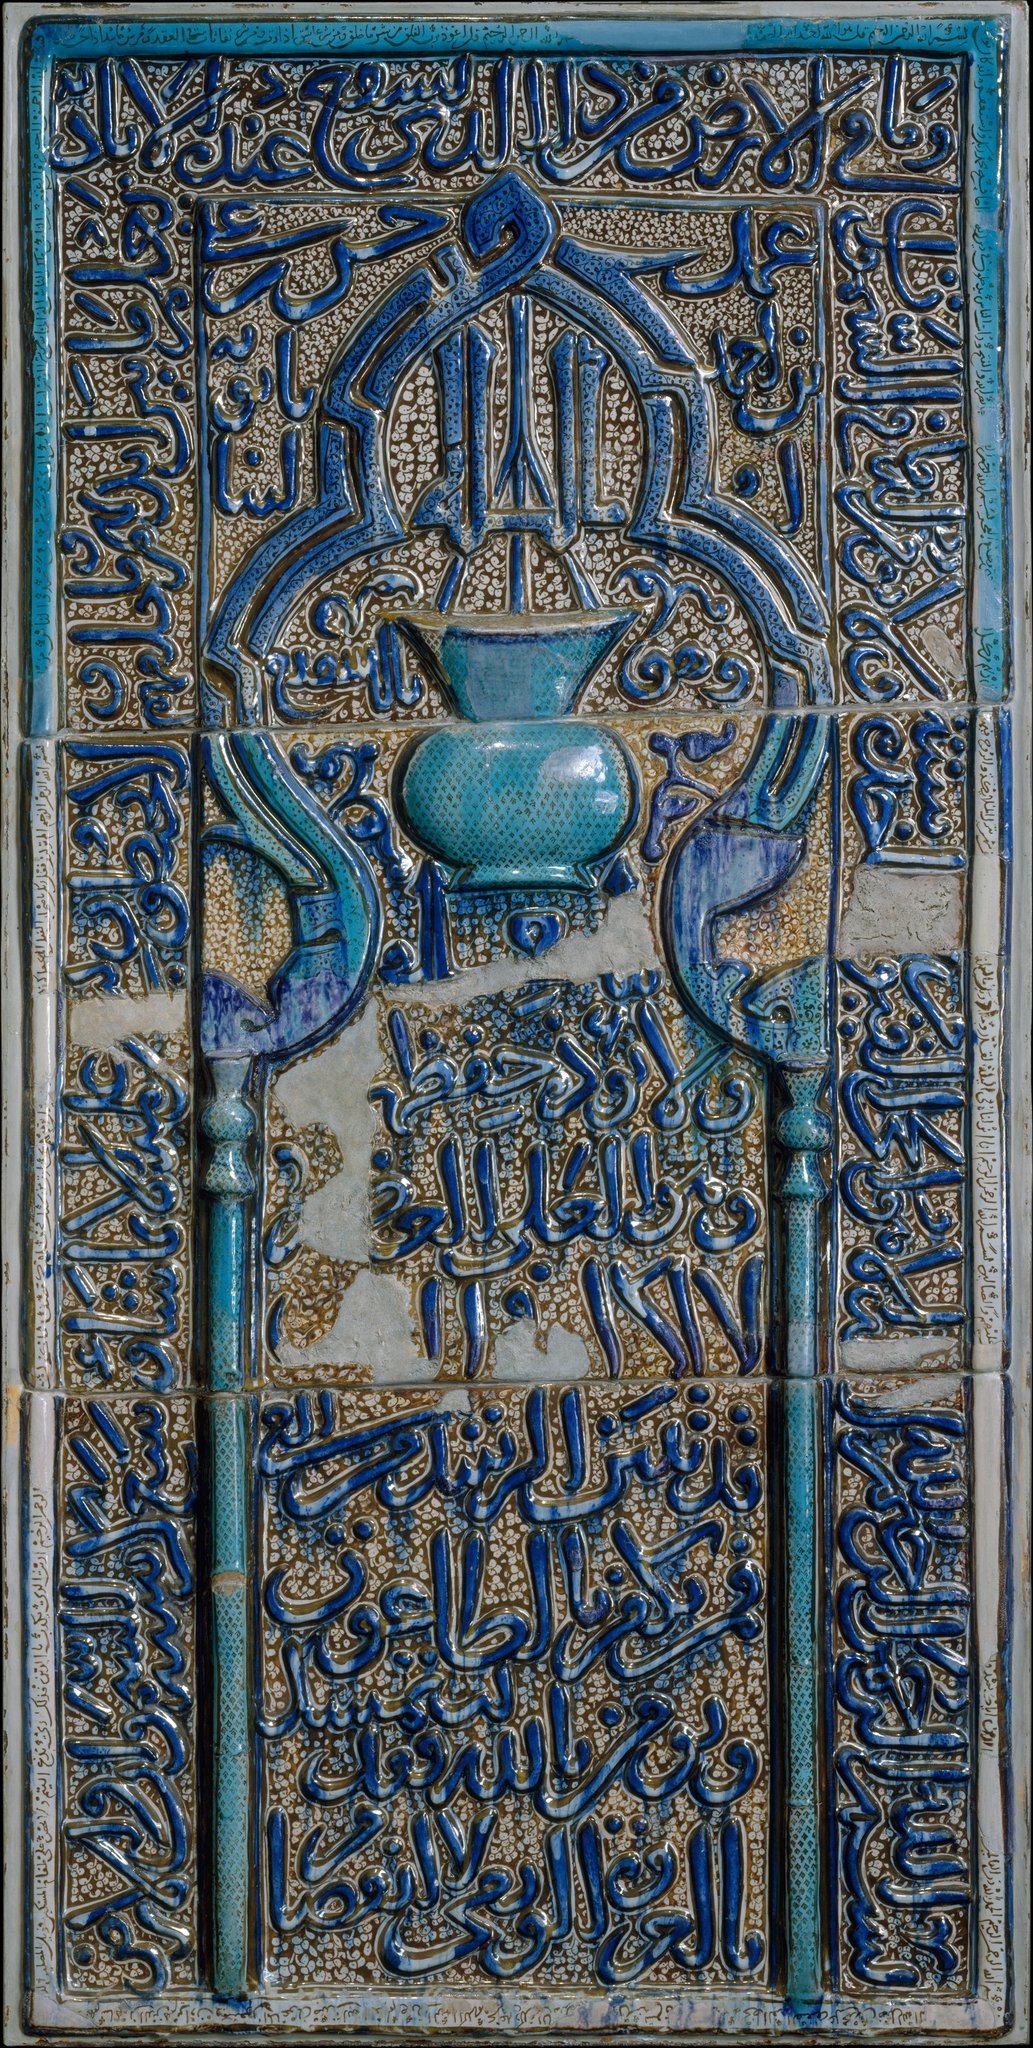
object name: tile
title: Tile Panel in the form of an Architectural Niche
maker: hasan ibn `ali ibn ahmad babavaih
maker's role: maker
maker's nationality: iranian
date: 1301-1350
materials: glaze, stonepaste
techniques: luster painting, painting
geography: iran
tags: mihrabs